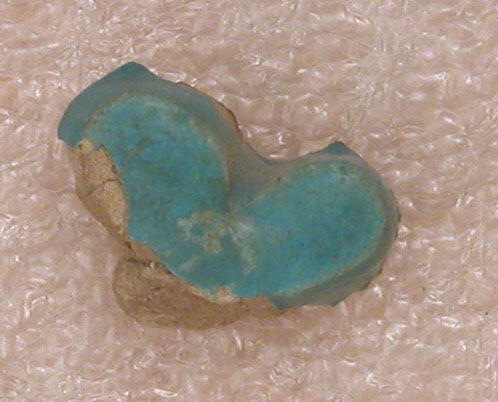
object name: tile fragment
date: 1334-1434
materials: stonepaste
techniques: glazing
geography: uzbekistan